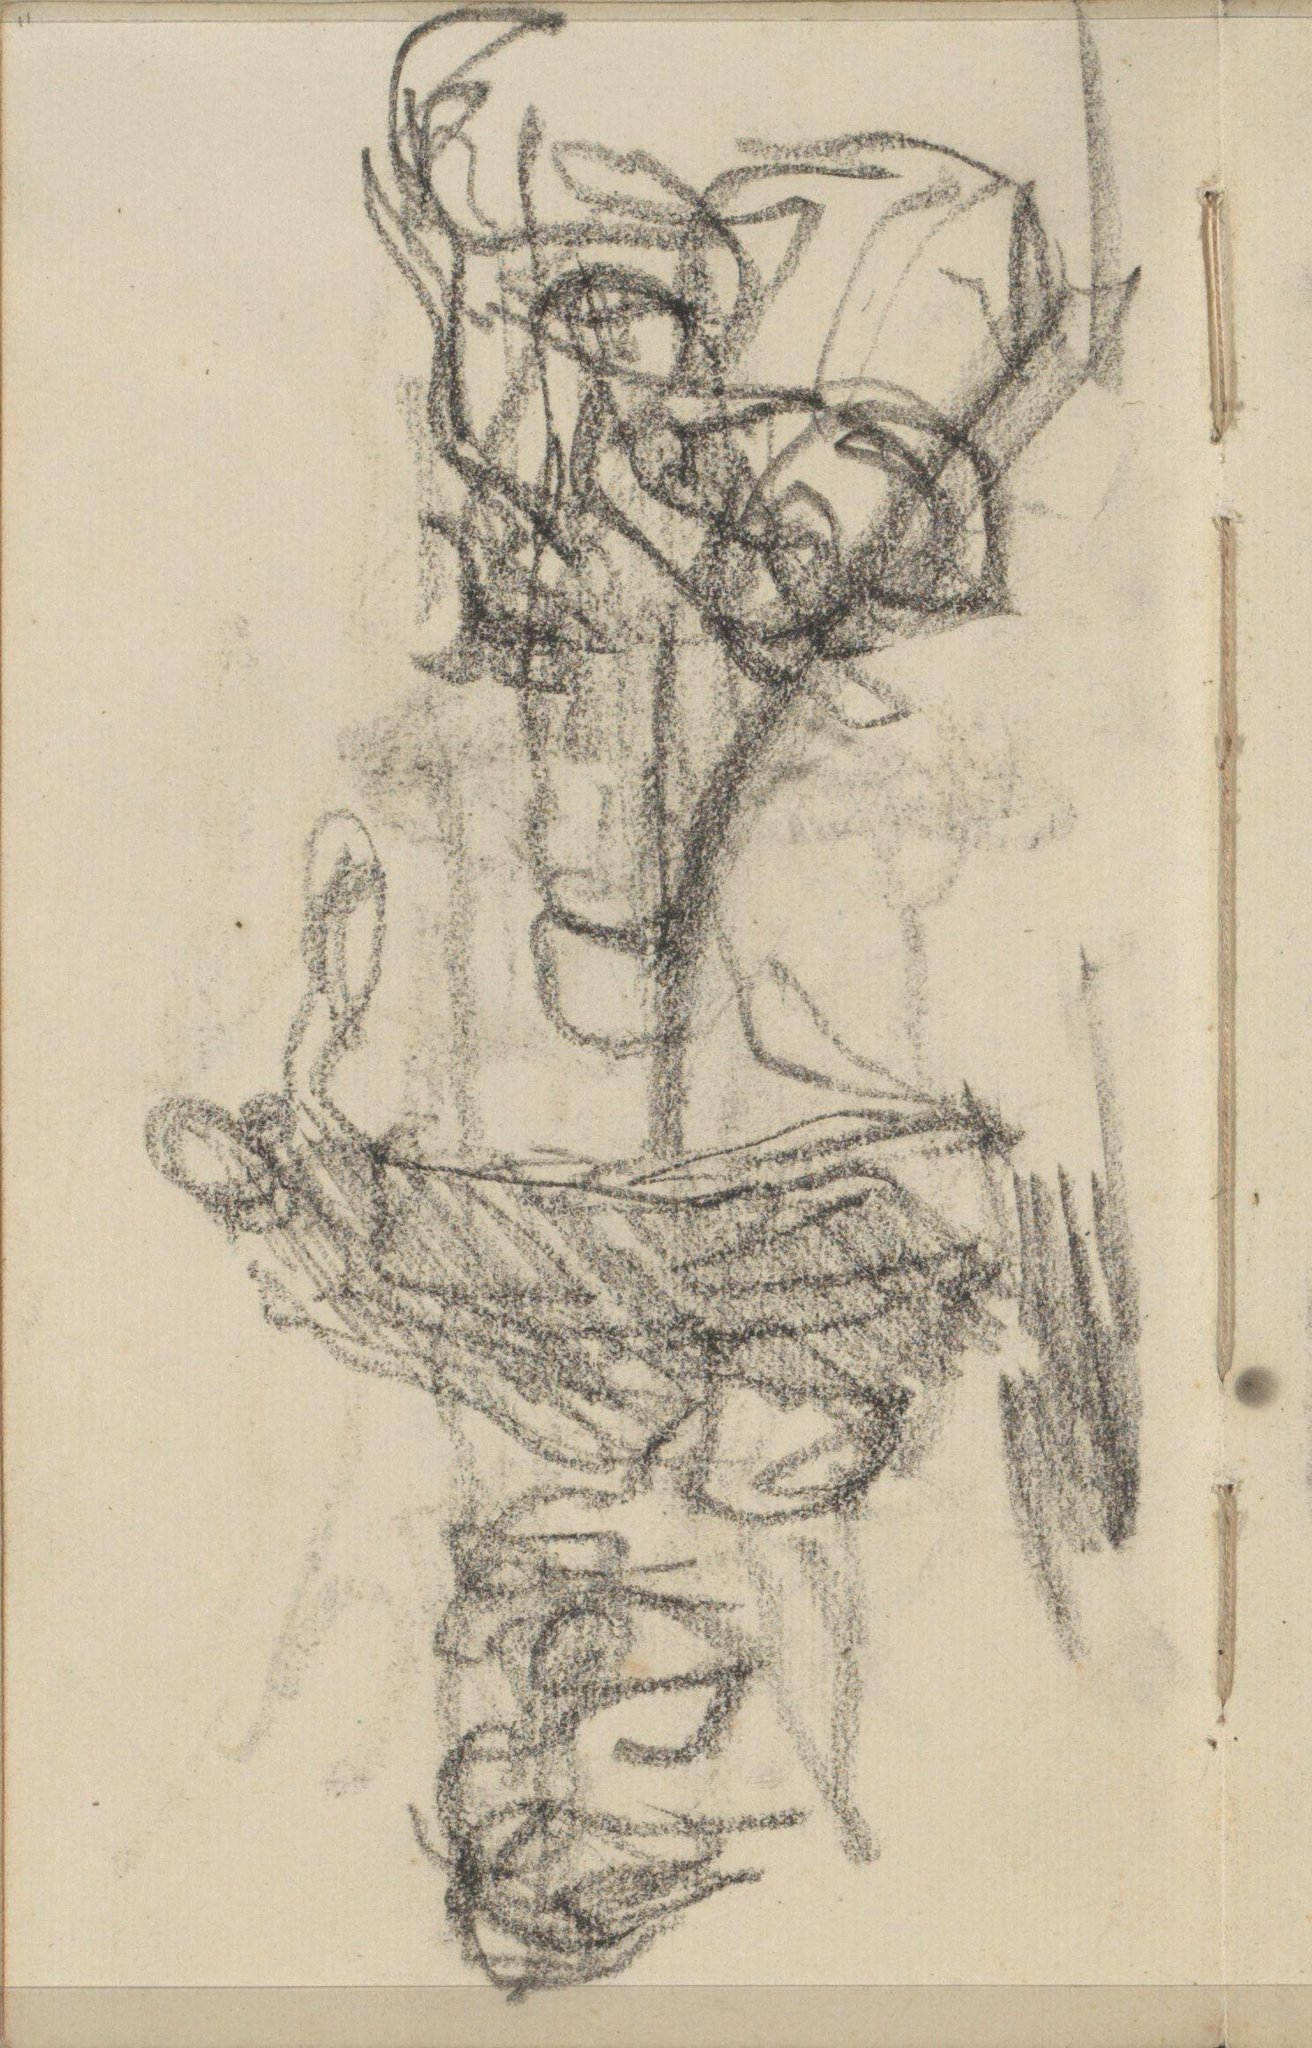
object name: sketchbook leaf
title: Figuurstudie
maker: george hendrik breitner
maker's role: draughtsman, painter, print maker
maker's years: 1857-1923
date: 1880-1882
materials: chalk, paper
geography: the hague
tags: cattle, adult man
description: Mogelijk wordt de figuur door vee omringd. Pagina 11 uit een schetsboek met 25 bladen.